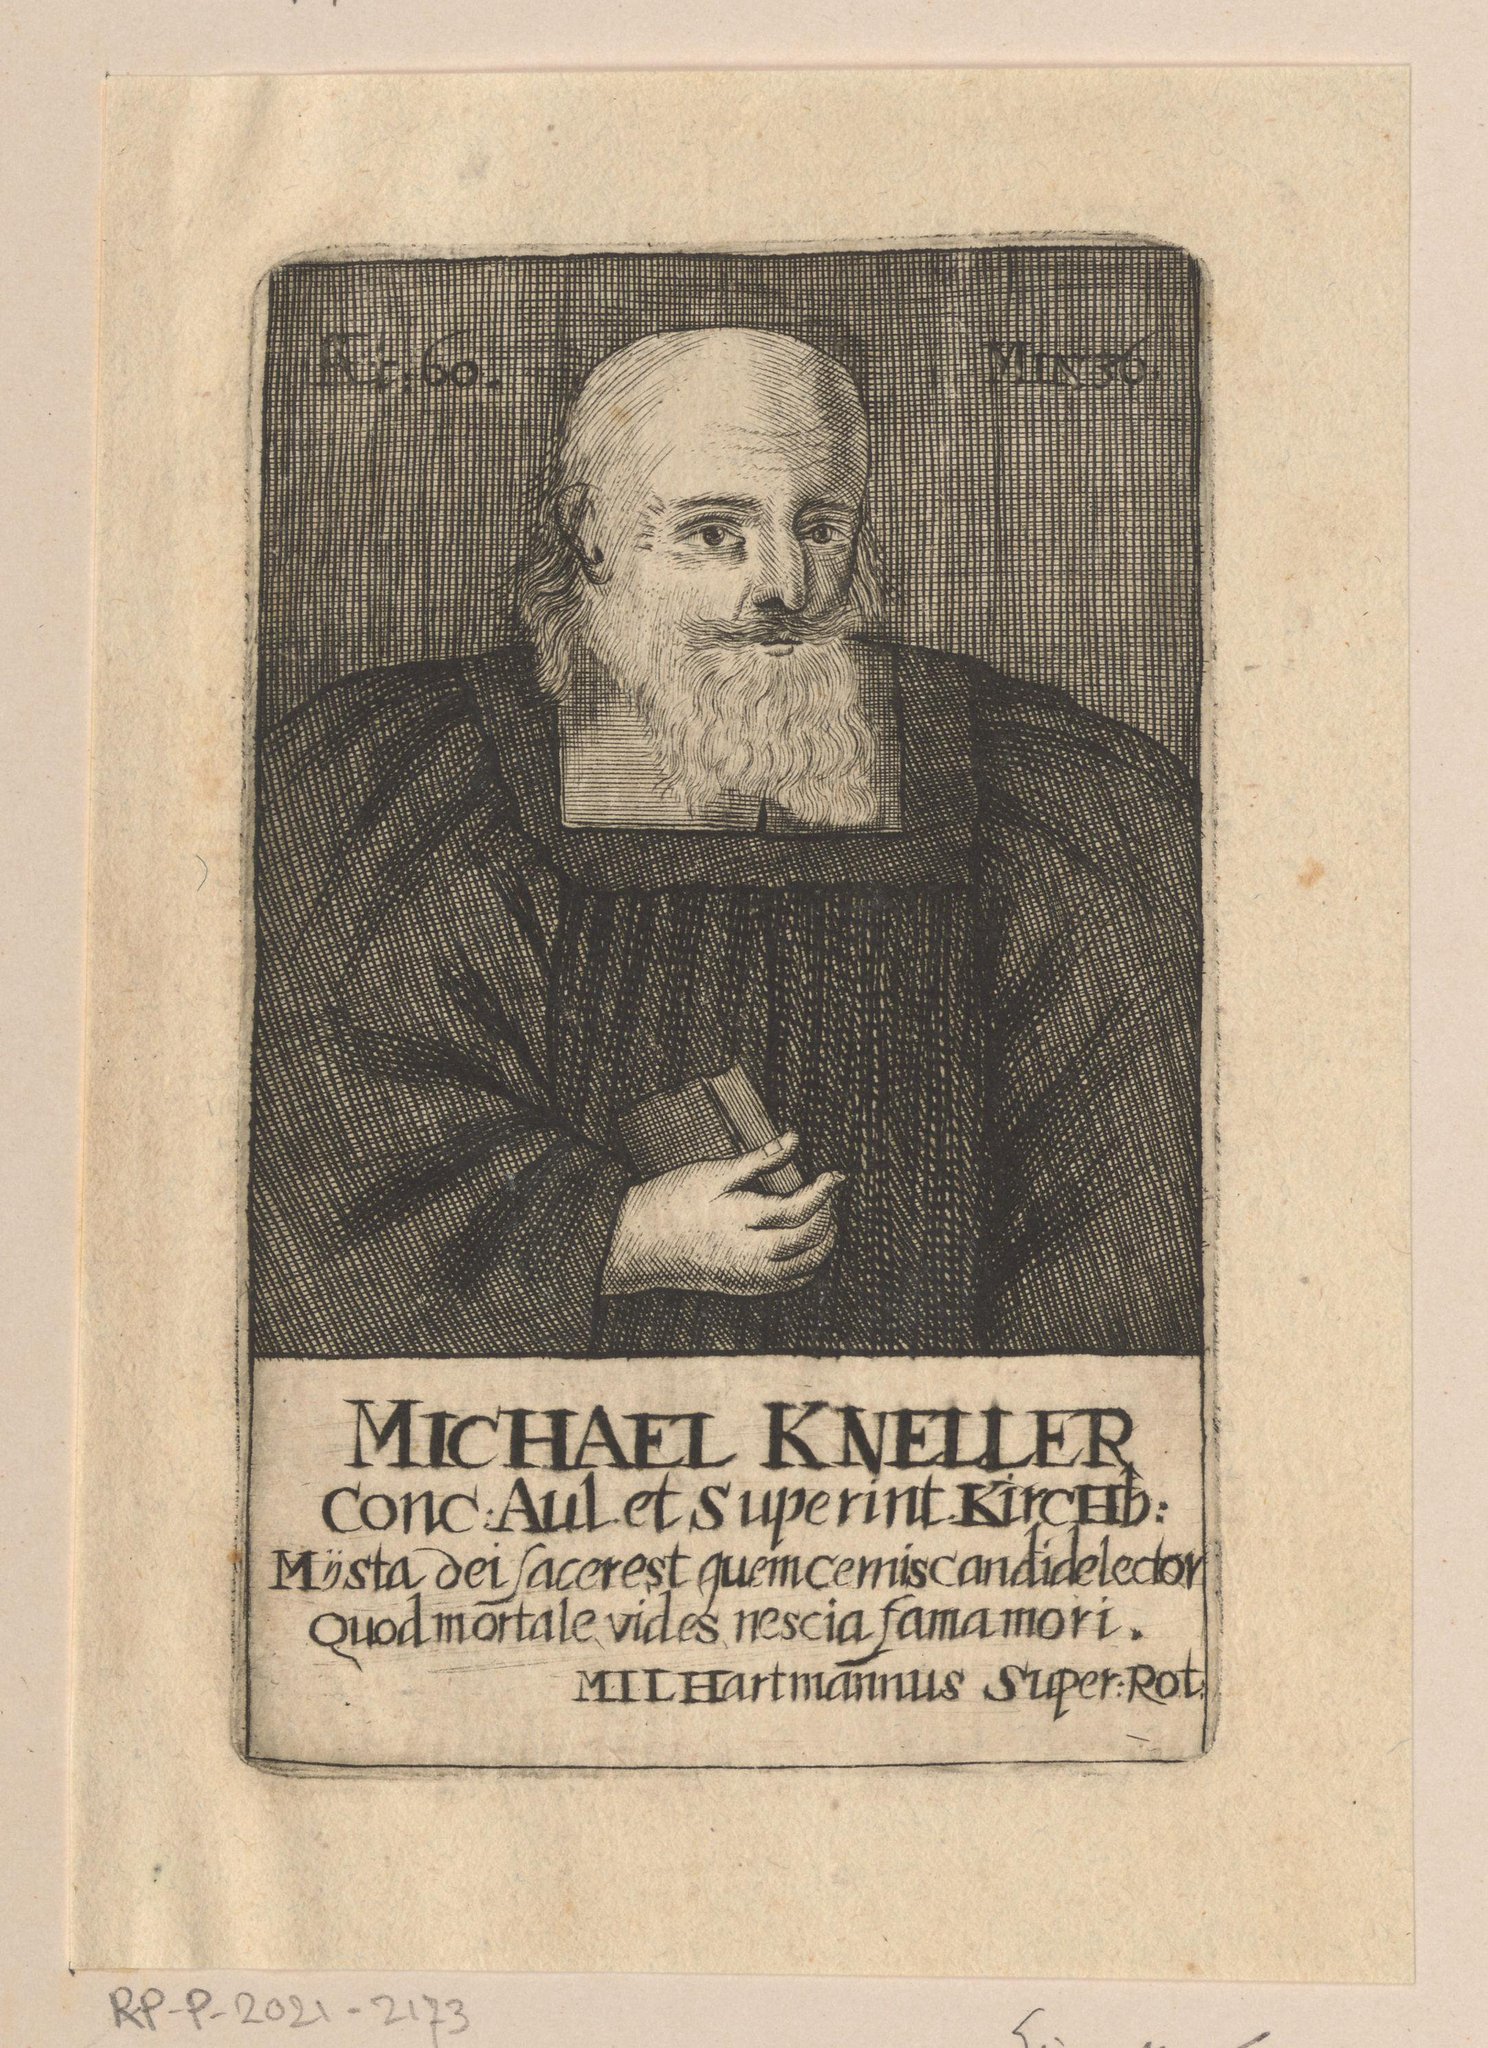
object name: print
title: Portret van Michael Kneller op 60-jarige leeftijd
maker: Anonymous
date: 1669-1699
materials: paper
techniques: engraving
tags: historical persons